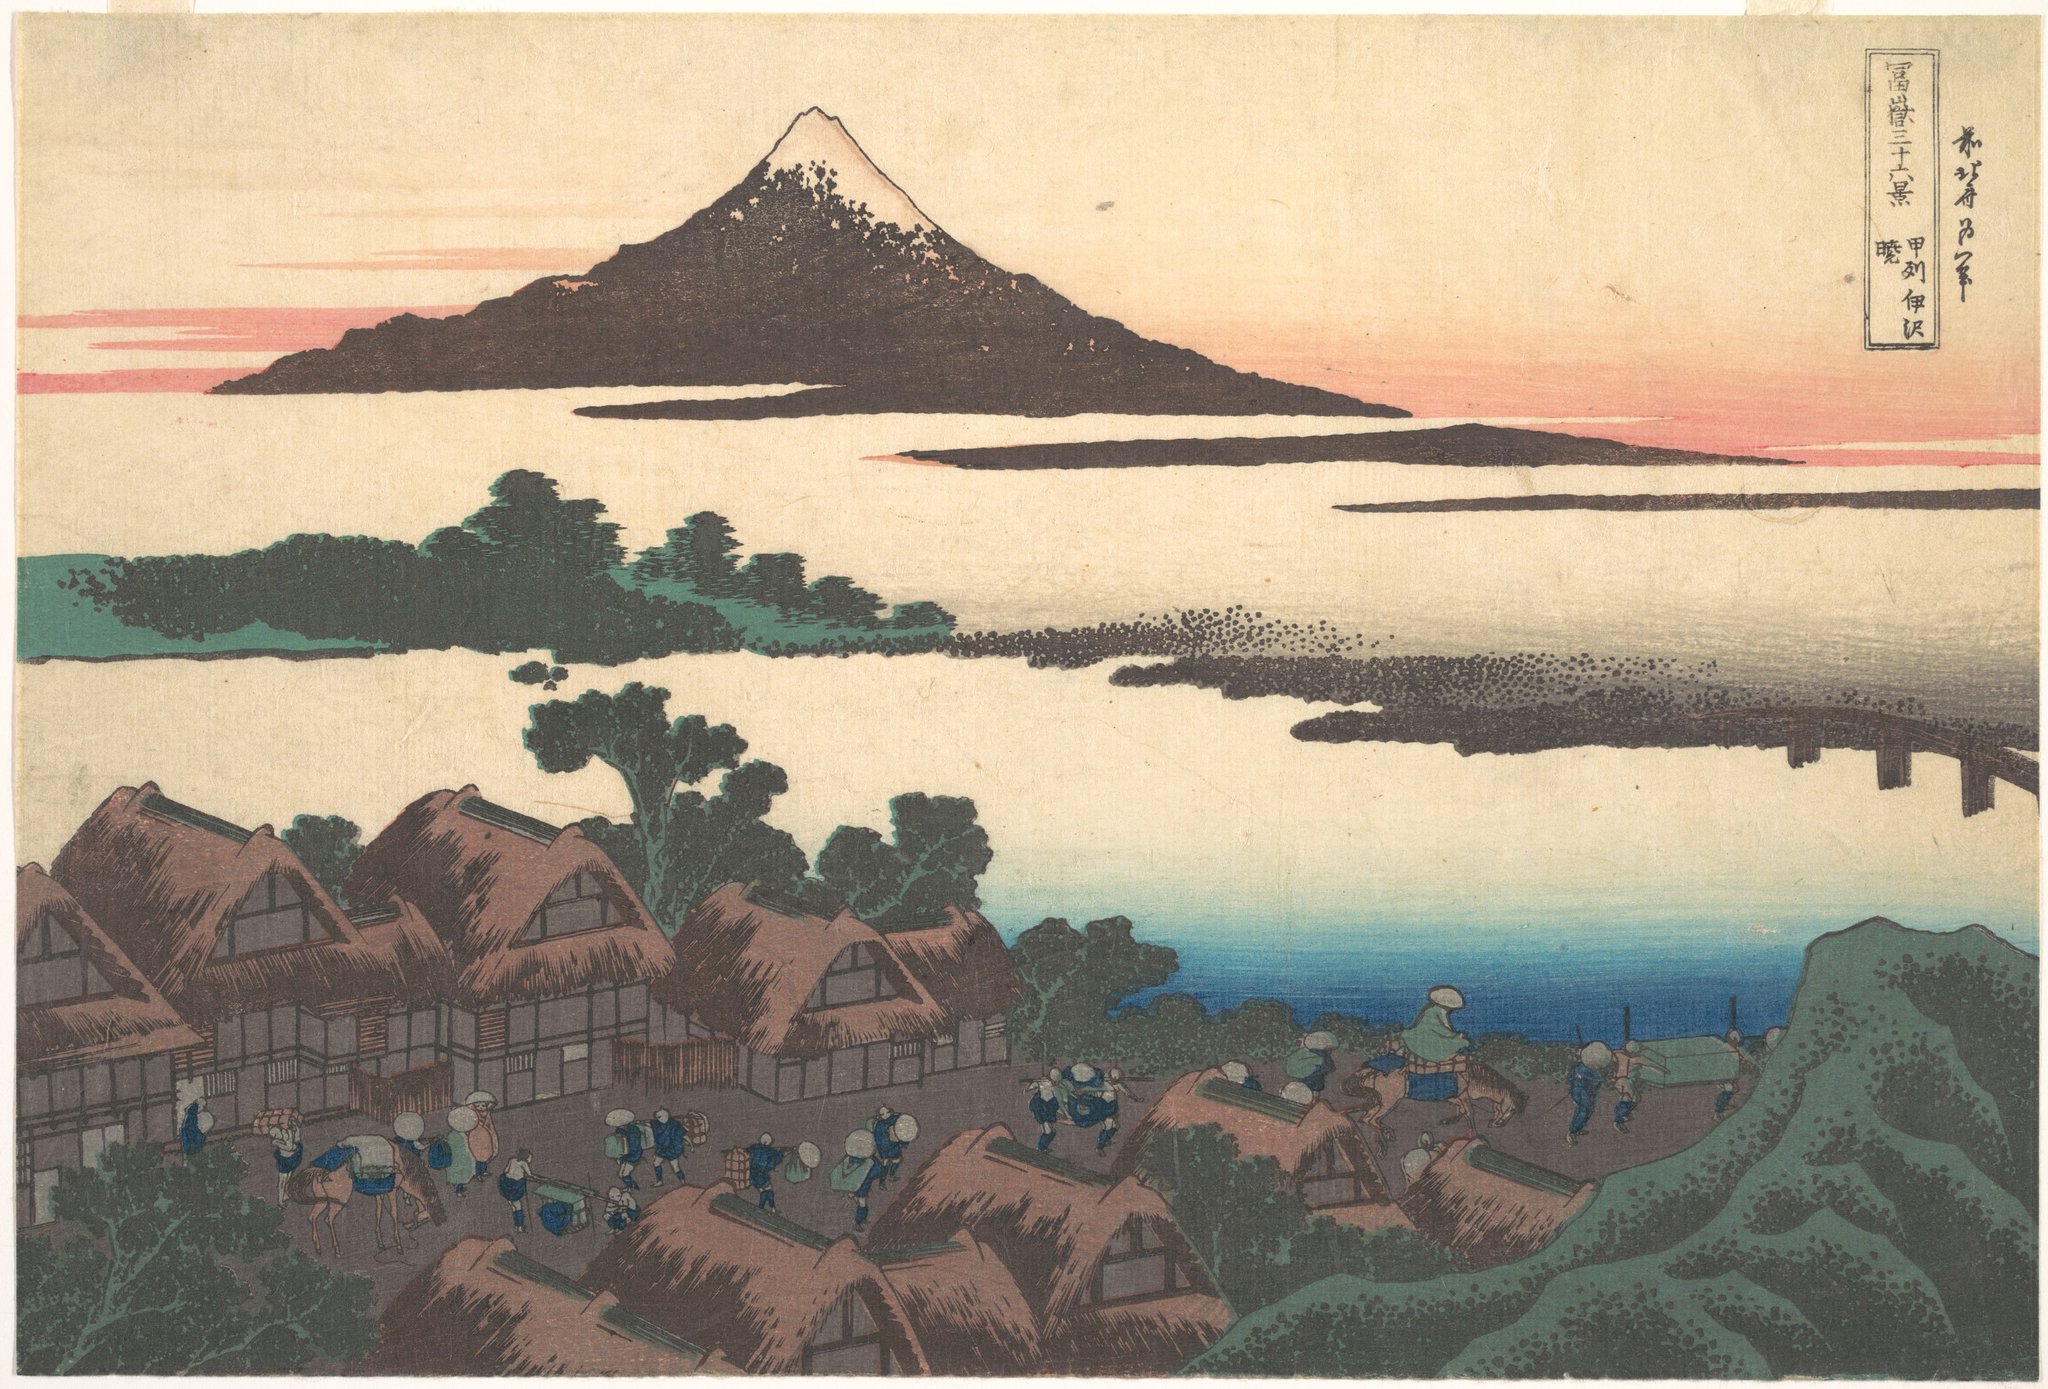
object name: woodblock print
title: Dawn at Isawa in Kai Province (Kōshū Isawa no akatsuki), from the series Thirty-six Views of Mount Fuji (Fugaku sanjūrokkei)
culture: japanese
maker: katsushika hokusai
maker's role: artist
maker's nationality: japanese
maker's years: 1760-1849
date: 1830-1832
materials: ink, paper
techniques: woodblock print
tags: houses,horses,rivers,volcanoes,dawn